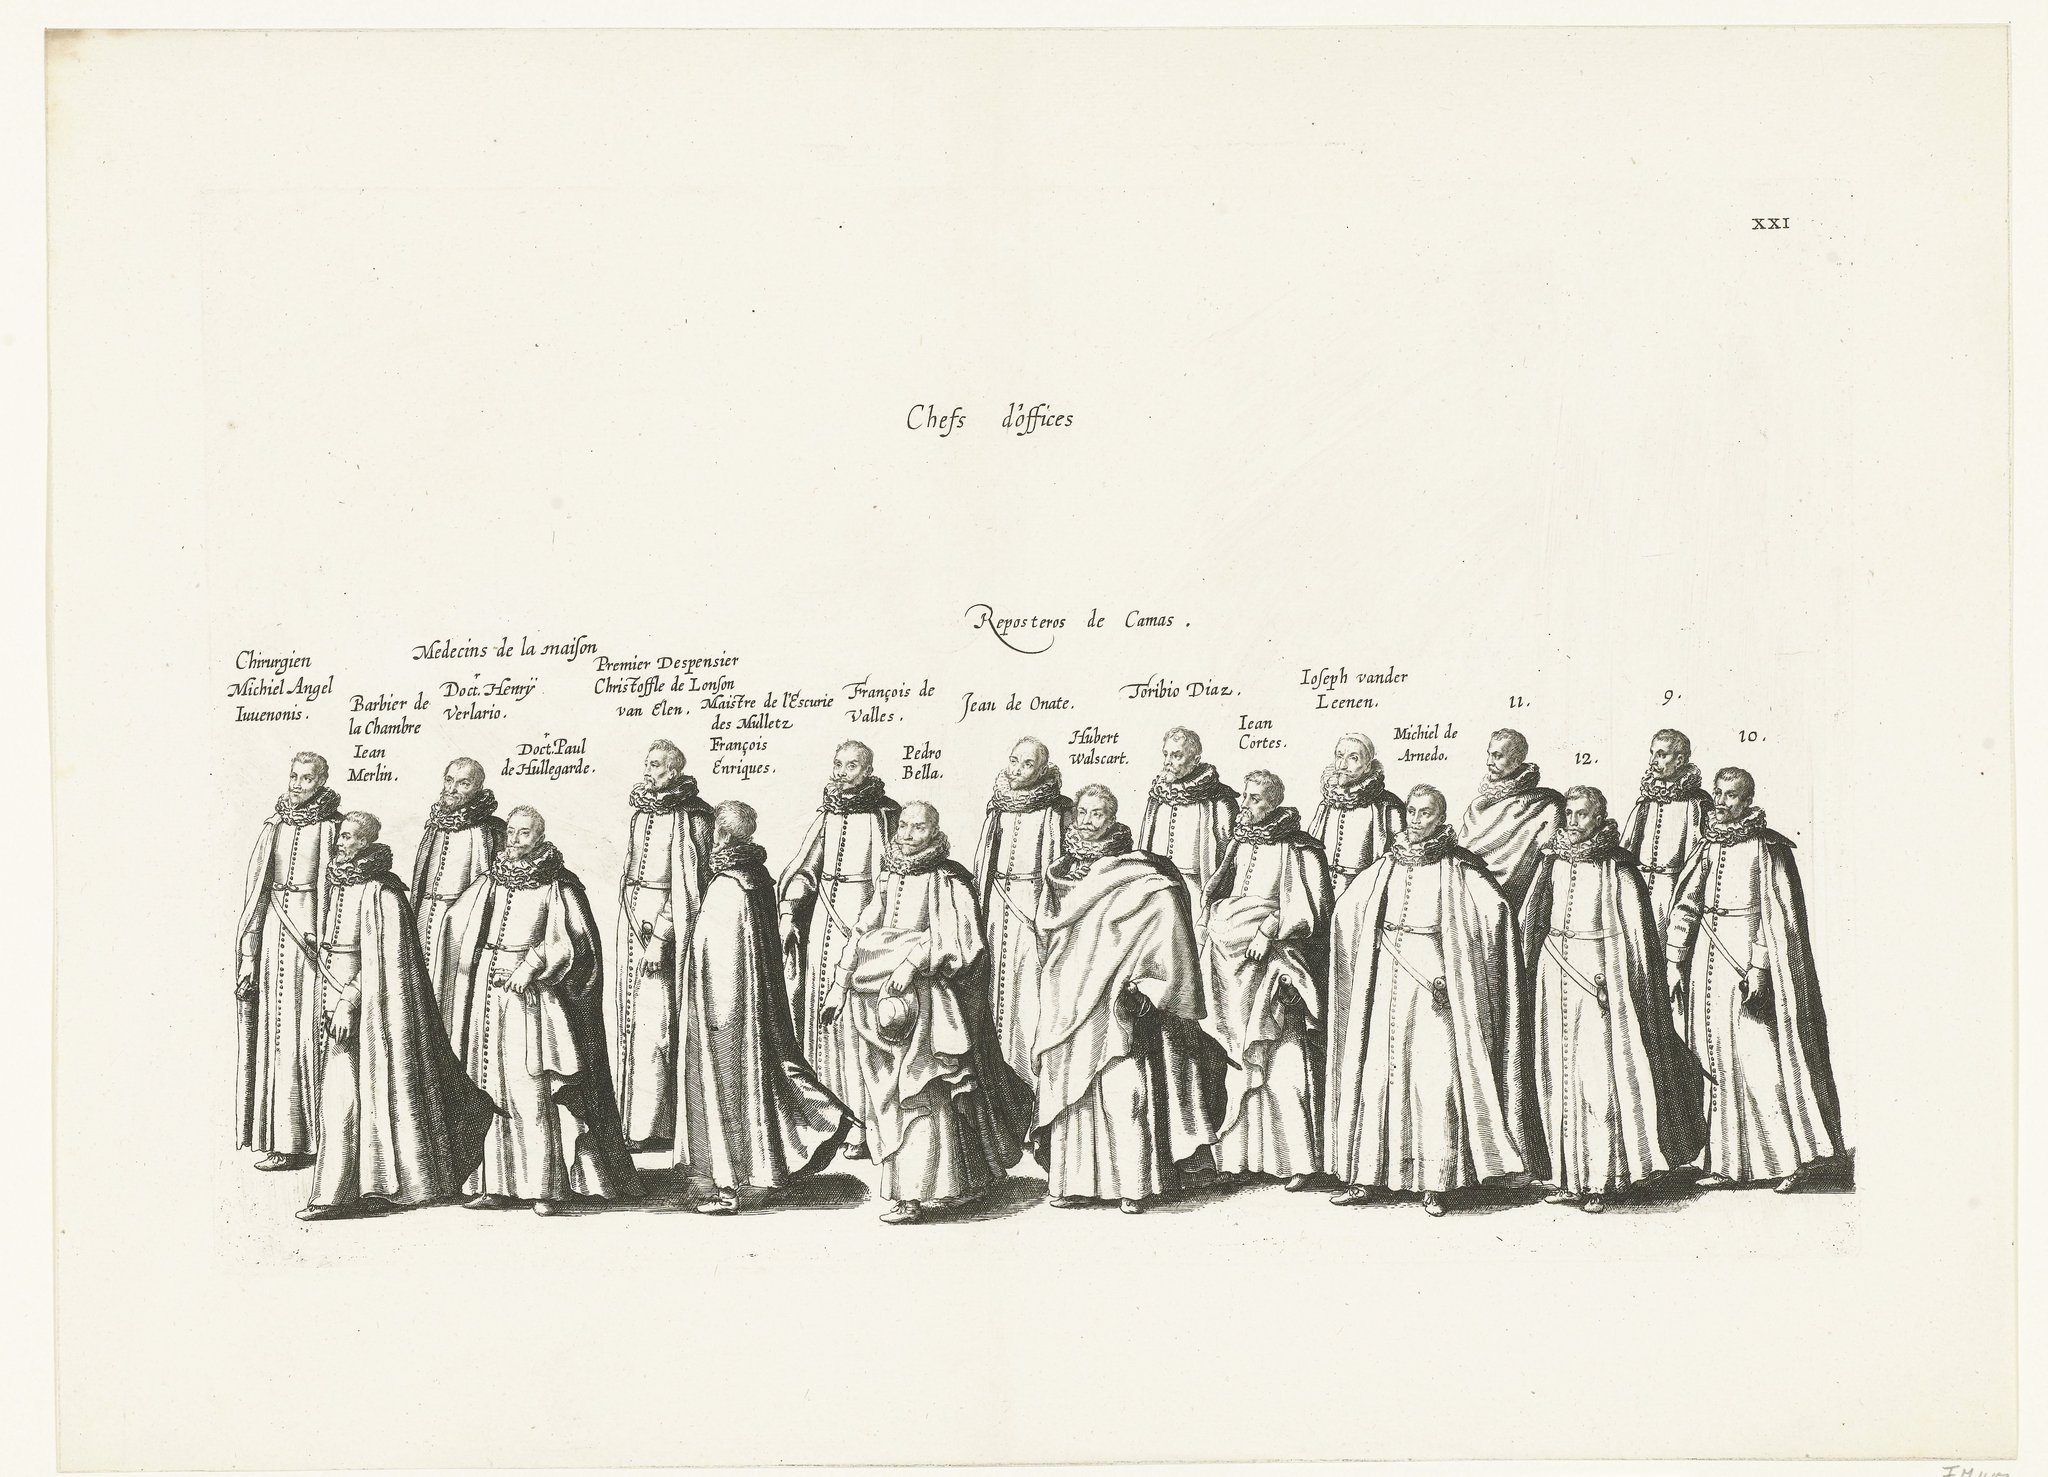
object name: print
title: Pompa funebris optimi potentissimiq. principis Alberti pii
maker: cornelis galle (i)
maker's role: print maker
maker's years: 1576-1650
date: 1623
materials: paper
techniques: etching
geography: southern netherlands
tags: brussels, albrecht aartshertog van oostenrijk, cortege, funeral procession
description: Deelnemers aan de begrafenisstoet. Plaat XXI in de serie van de begrafenis van aartshertog Albrecht van Oostenrijk te Brussel op 12 maart 1622.